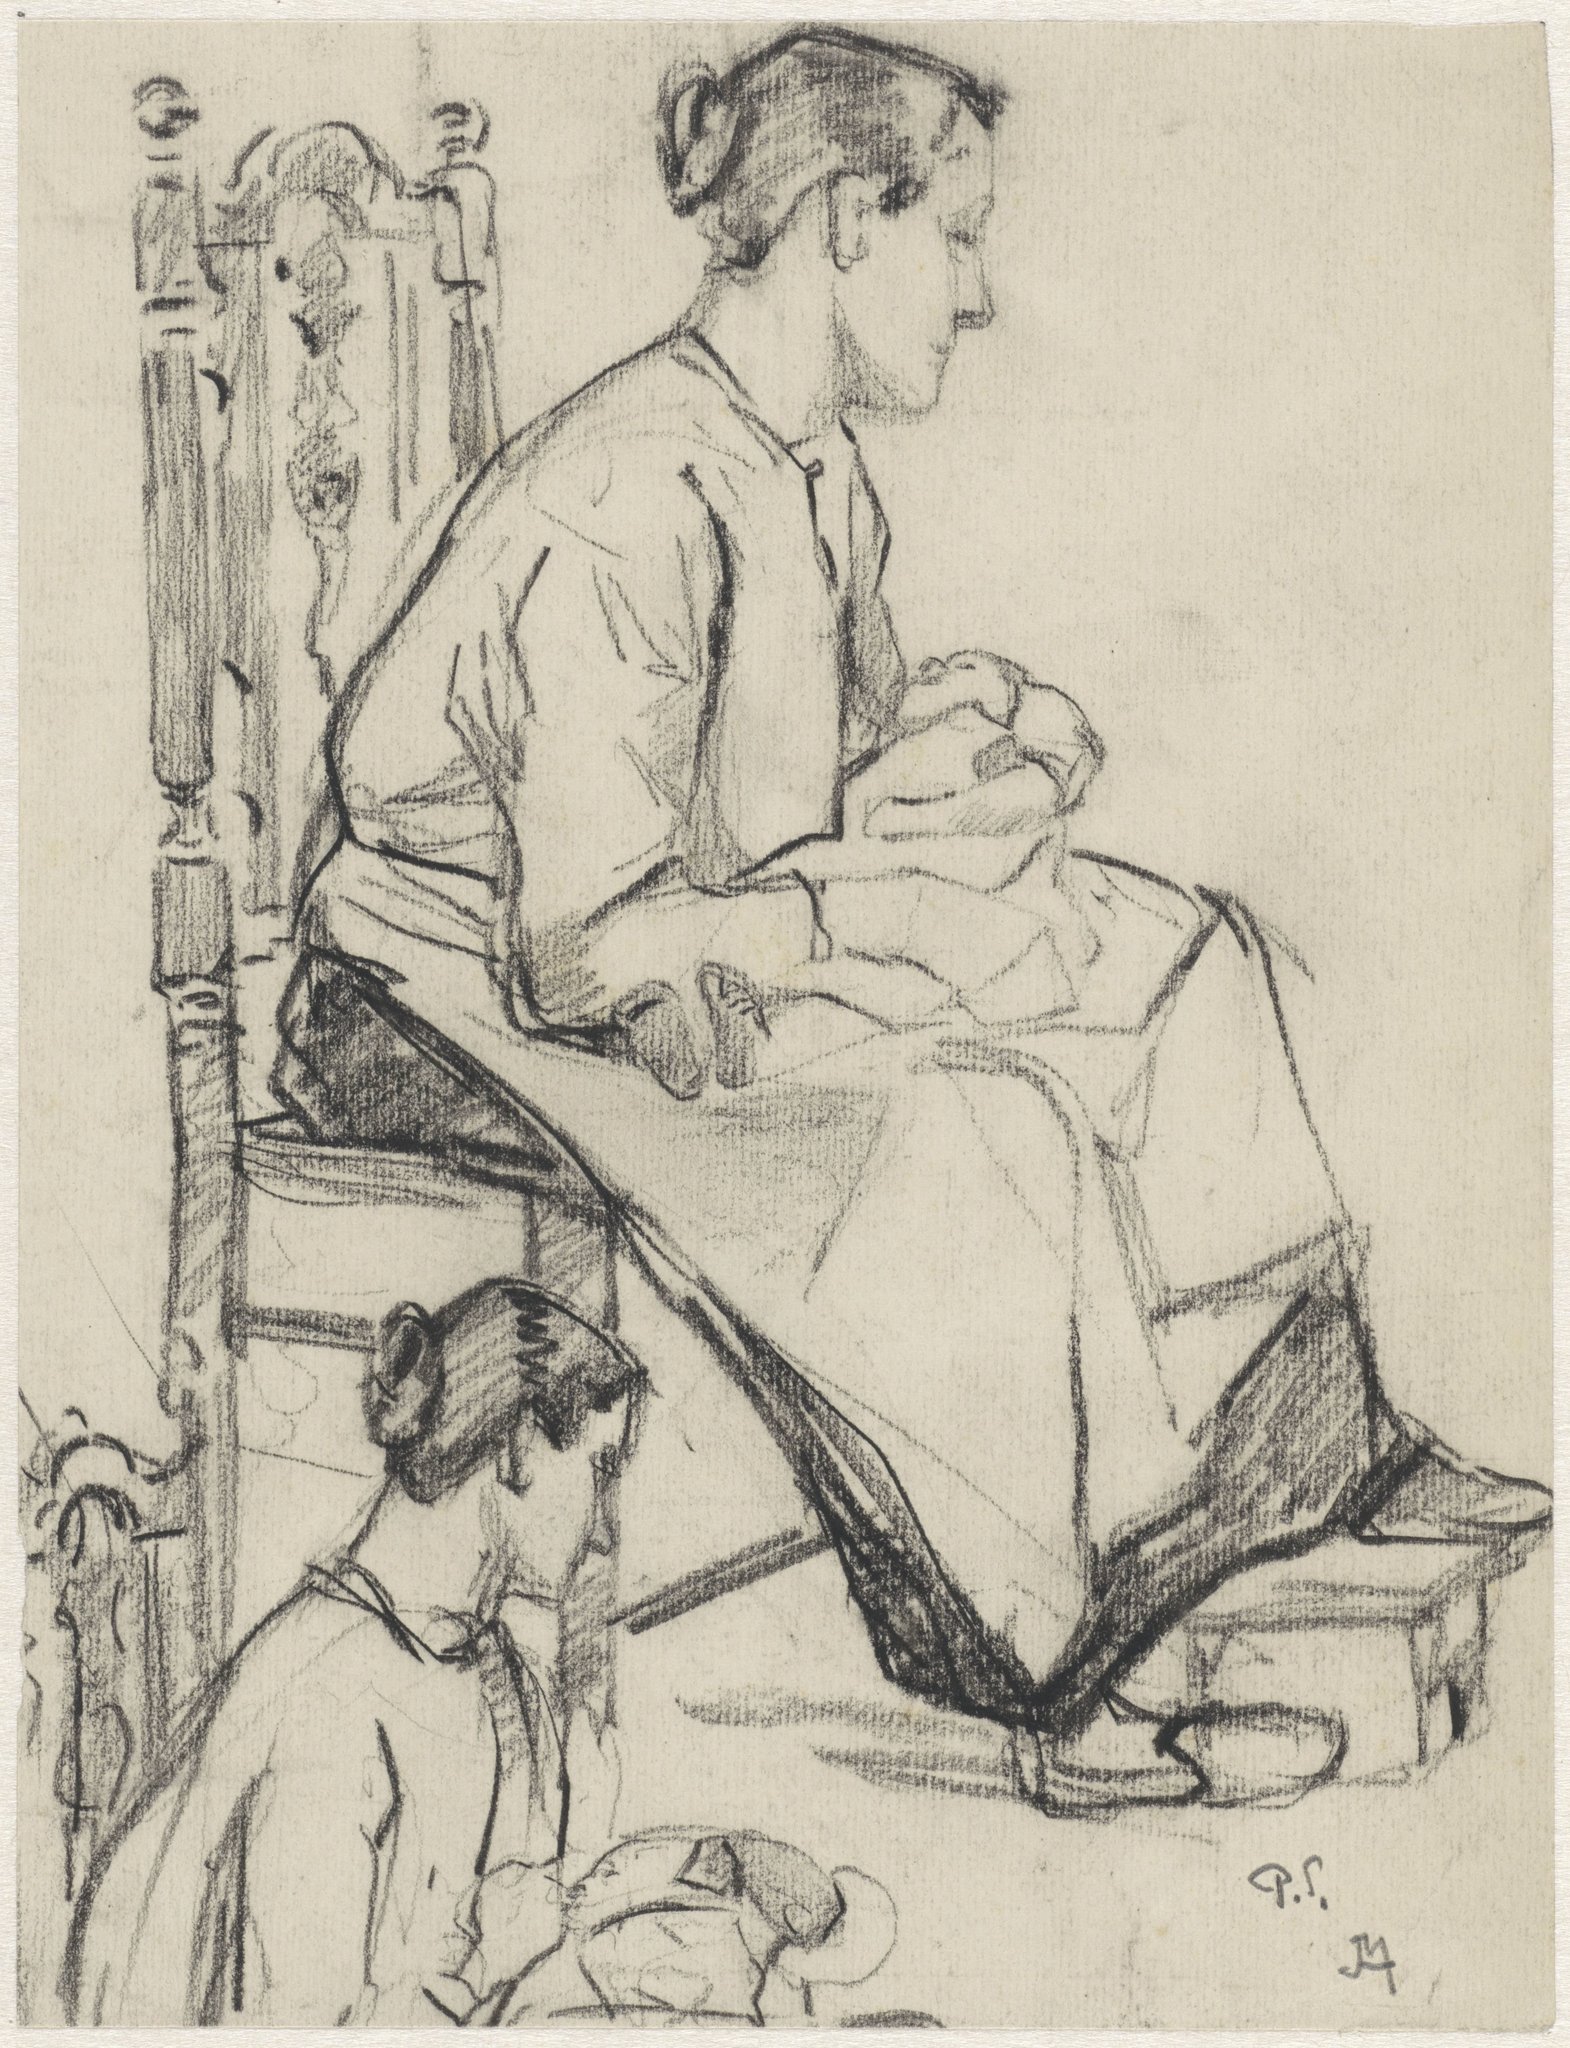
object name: drawing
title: Twee studies van een zittende vrouw met baby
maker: johannes abraham mondt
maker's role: draughtsman, print maker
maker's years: 1859-1941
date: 1869-1941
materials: chalk, paper